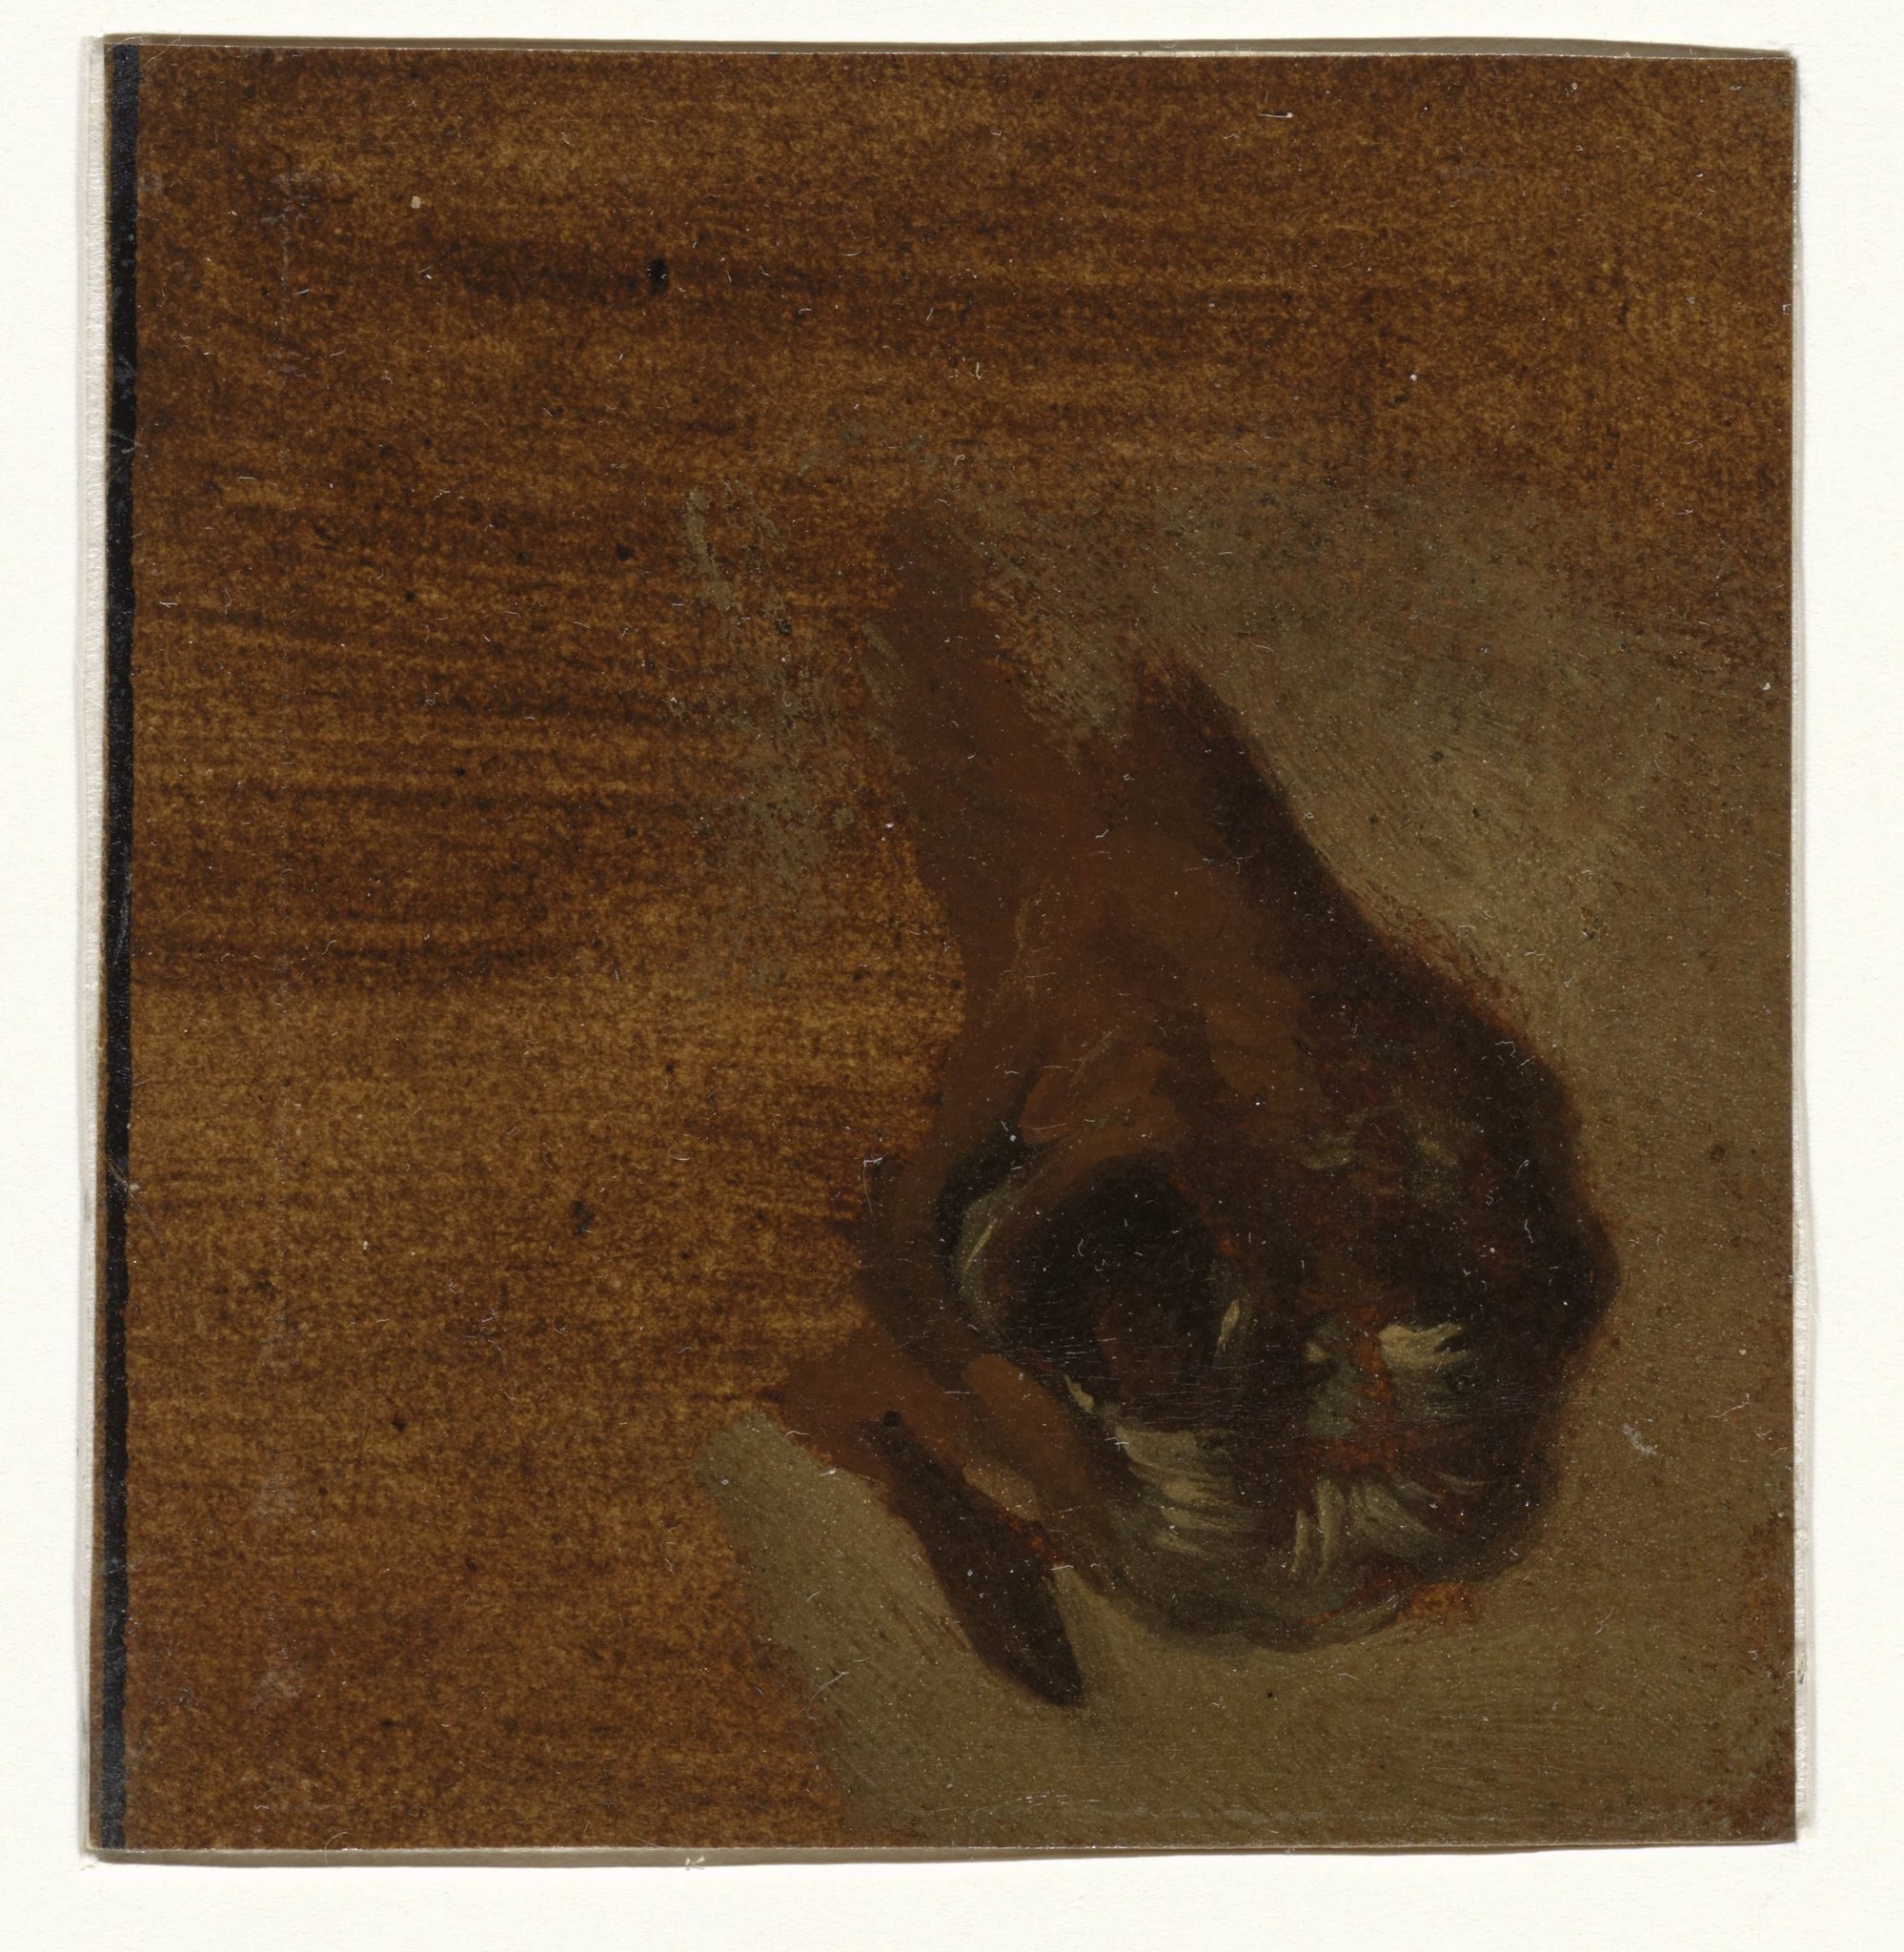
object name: drawing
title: Paardenhoofd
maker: henriëtte ronner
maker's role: draughtsman, painter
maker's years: 1821-1909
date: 1831-1909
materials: oil, paper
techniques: brush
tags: horse